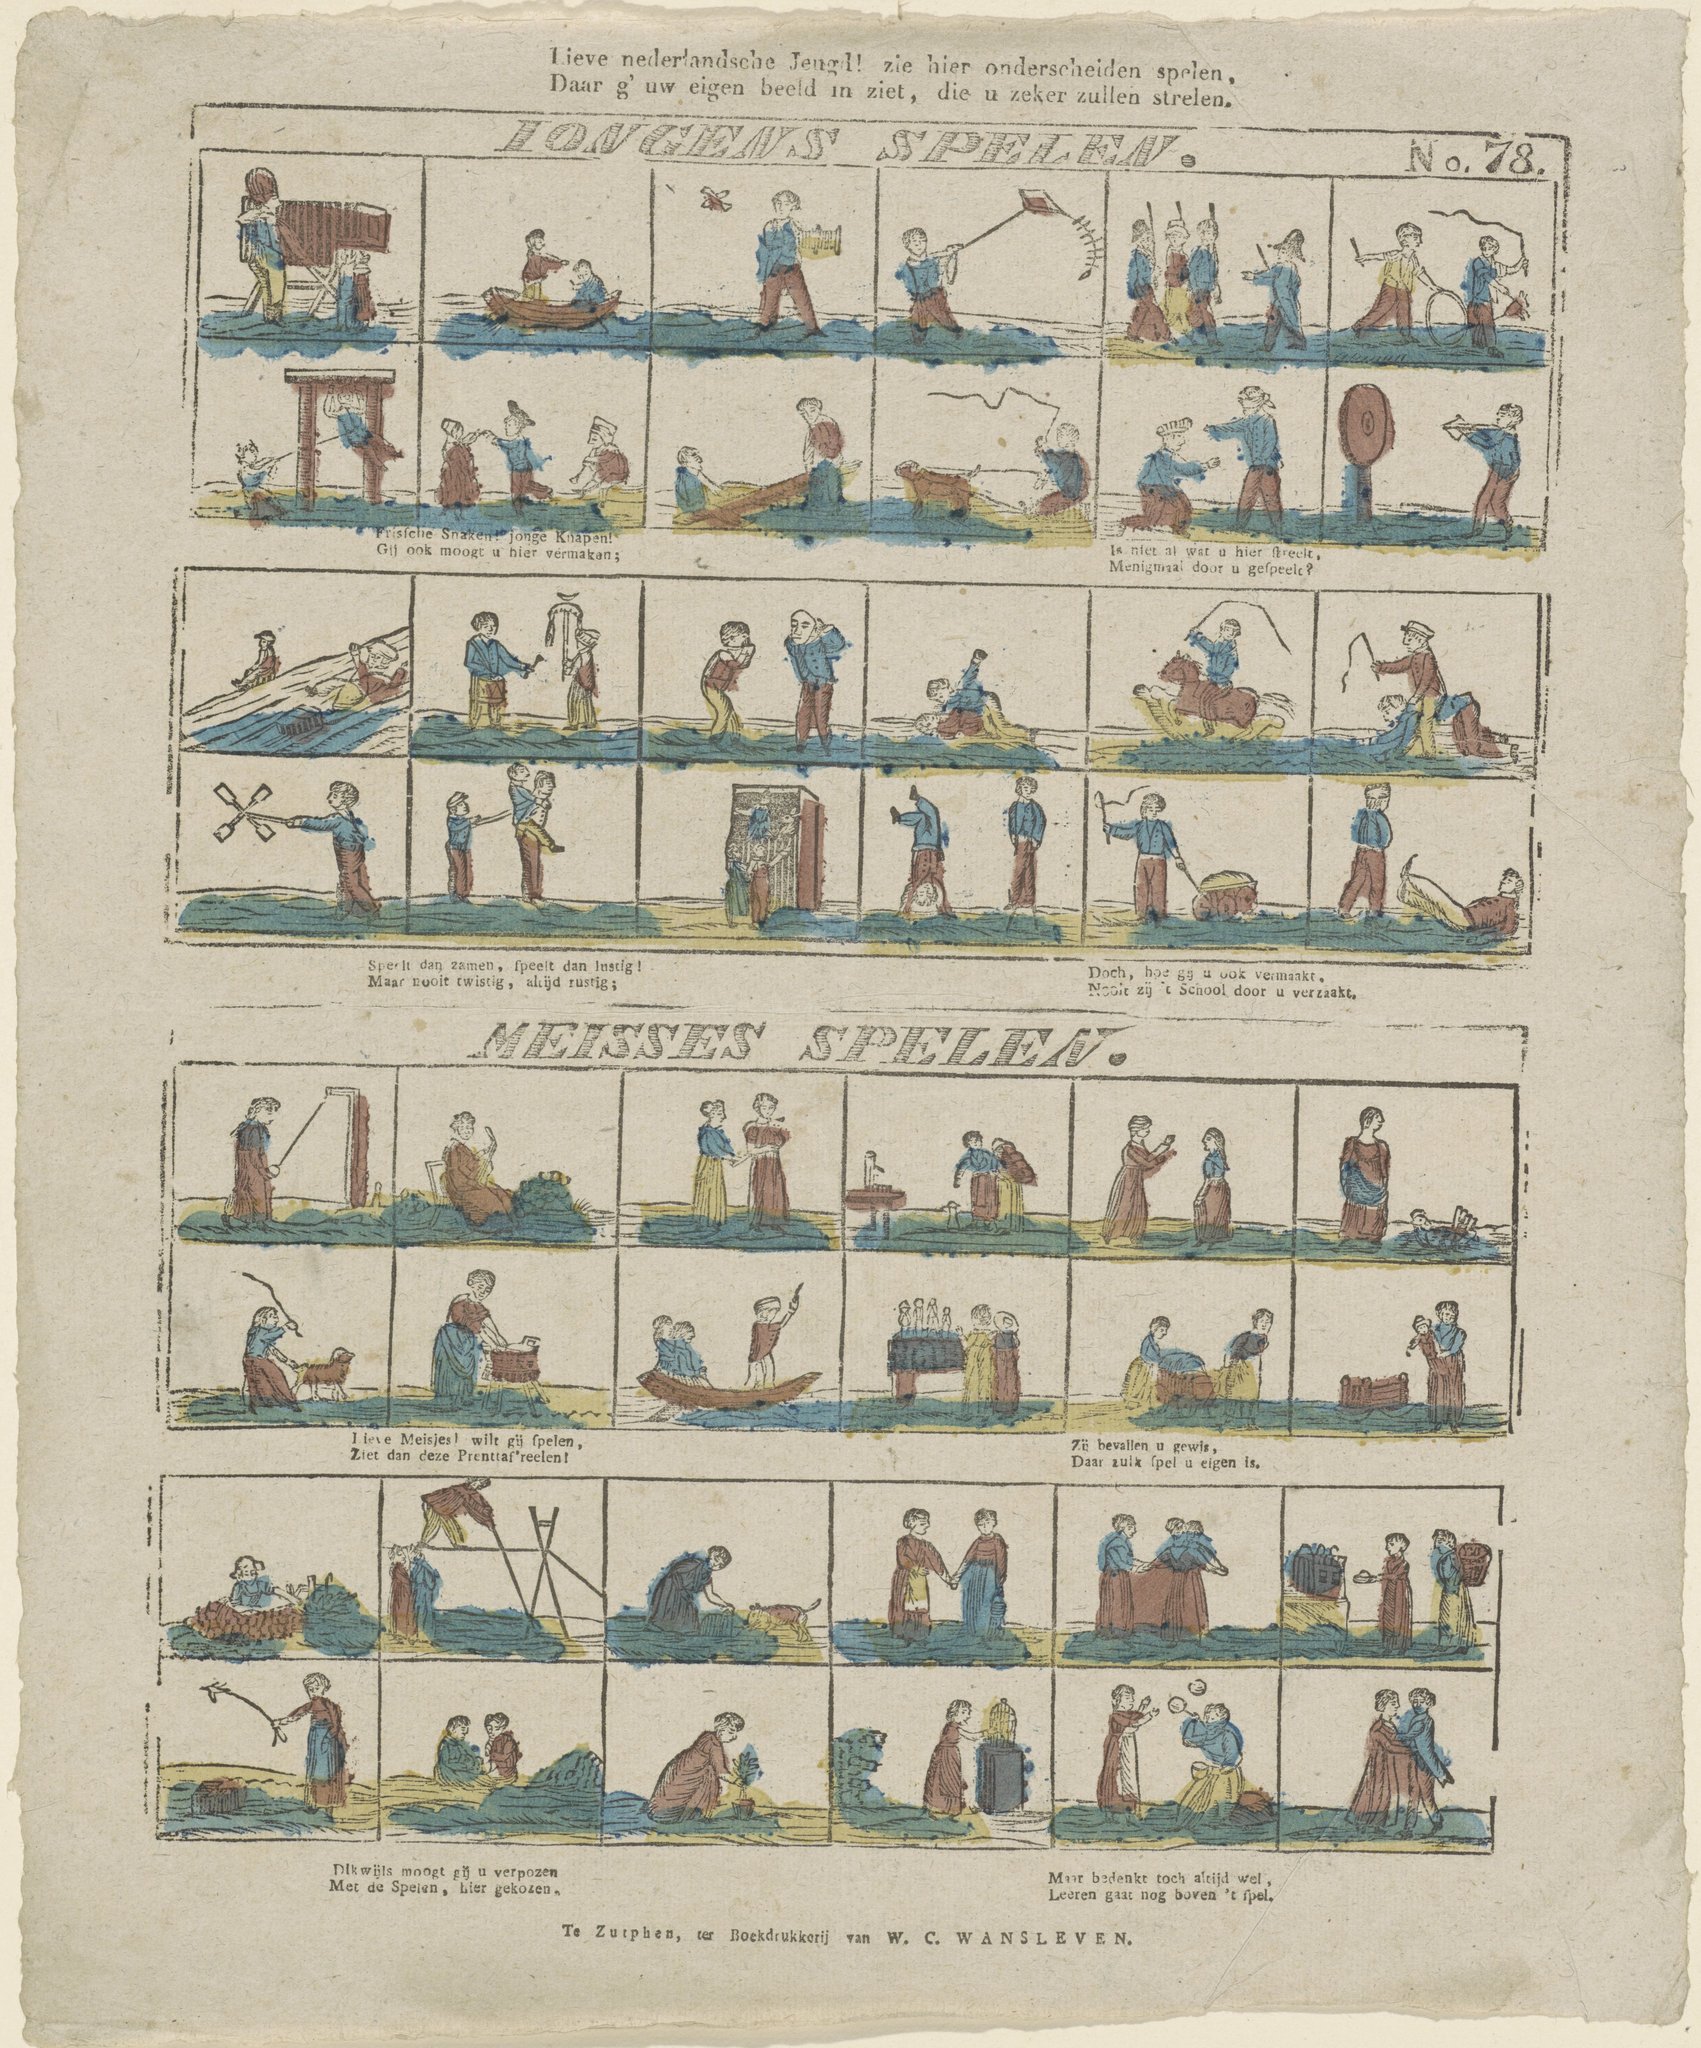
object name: print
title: Lieve nederlandsche jeugd! zie hier onderscheiden spelen, / Daar g' uw eigen beeld in ziet, die u zeker zullen strelen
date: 1806-1858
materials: paper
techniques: colour, letterpress printing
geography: netherlands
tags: children's games and plays, (playing with) dolls, child playing with animals, (flying a) kite, games using special objects (marbles, top, hoop, etc.), seesaw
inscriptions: collector's mark: Lugt 2760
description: Blad met 4 horizontale rijen met voorstellingen van kinderspelen voor jongens of meisjes, zoals vliegeren, wippen, hobbelpaard rijden en met de pop spelen. Onder elke voorstelling een vierregelig vers in twee kolommen. Genummerd rechtsboven in de bovenste voorstelling: No. 78.